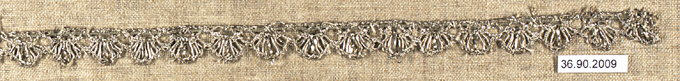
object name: piece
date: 1701-1800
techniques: lace